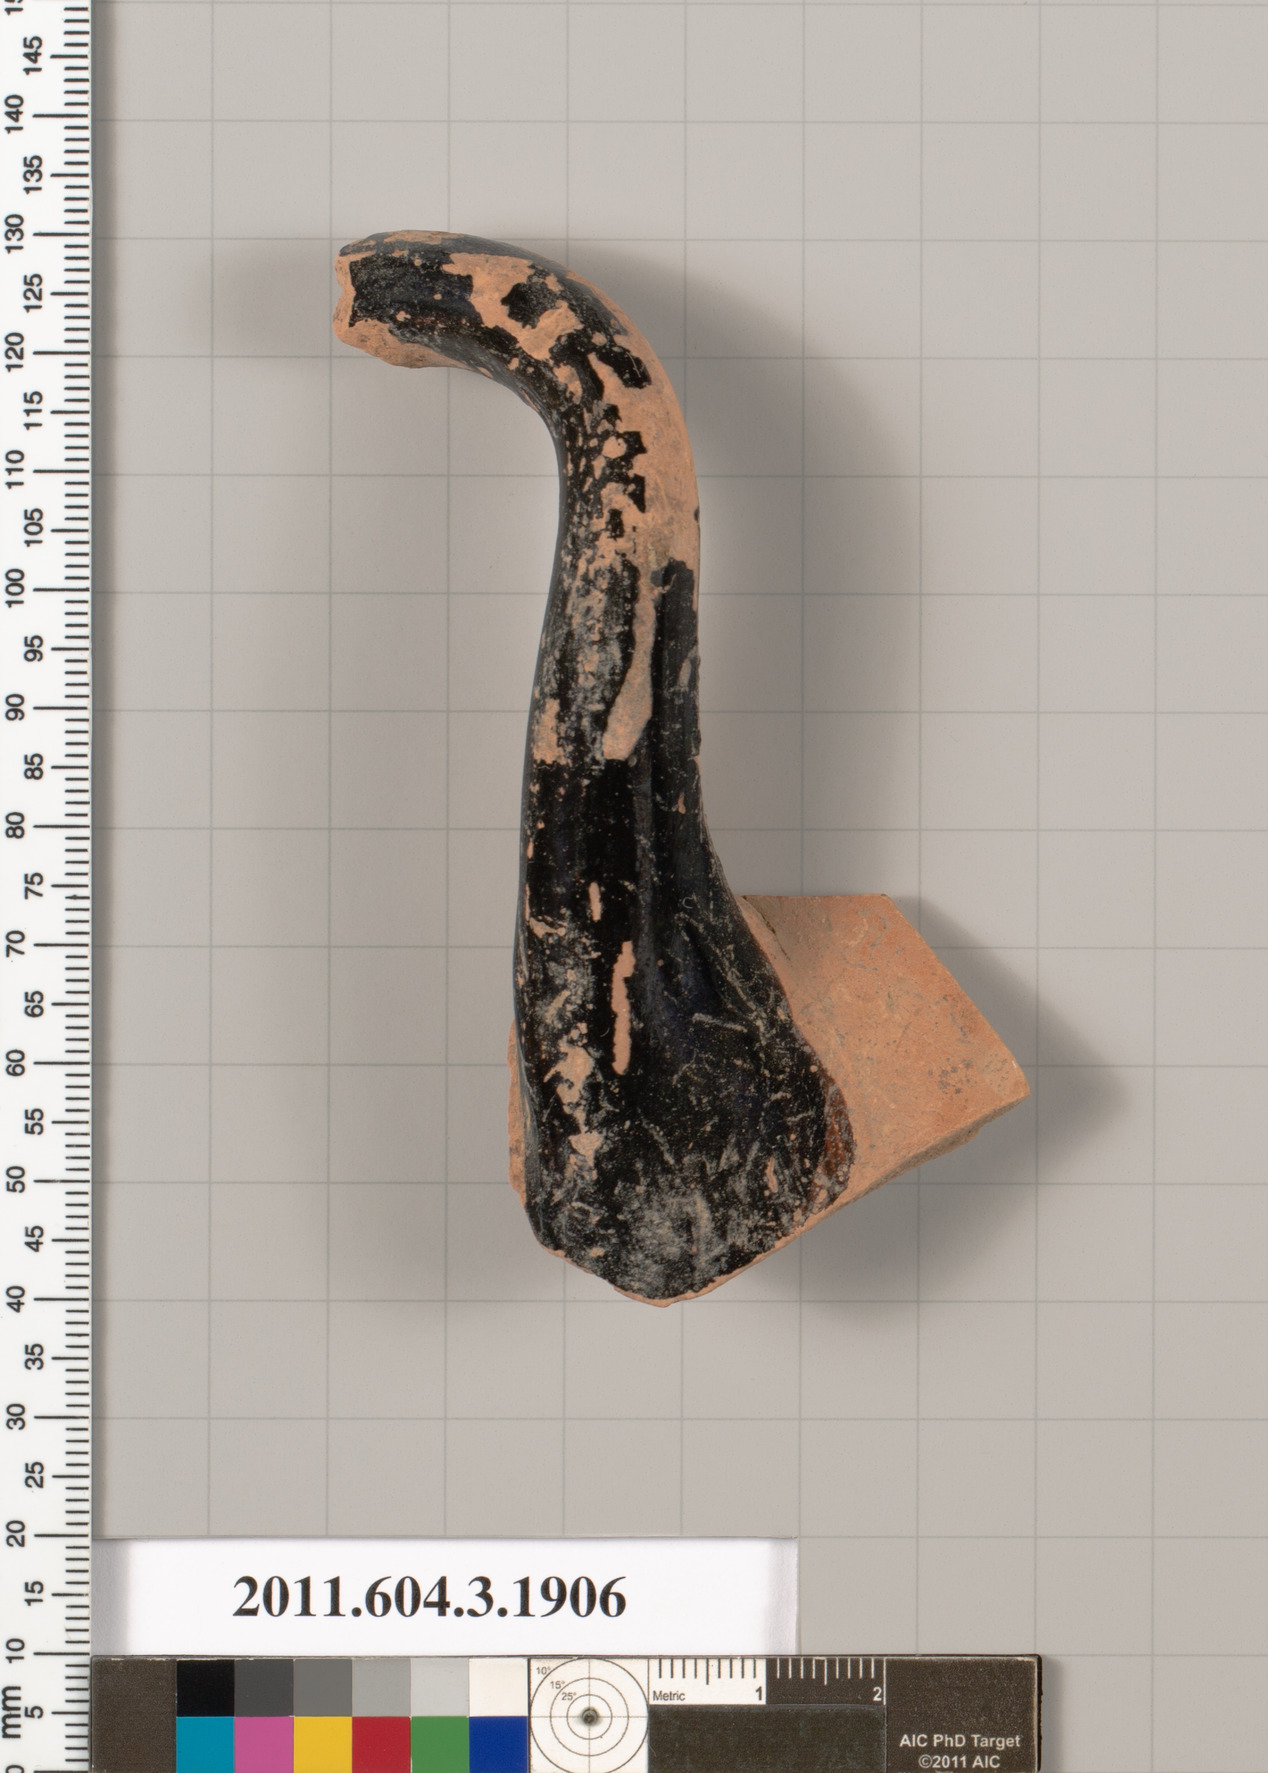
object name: kylix fragment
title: Terracotta fragment of a kylix (drinking cup)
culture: greek, attic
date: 600-401 BCE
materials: terracotta